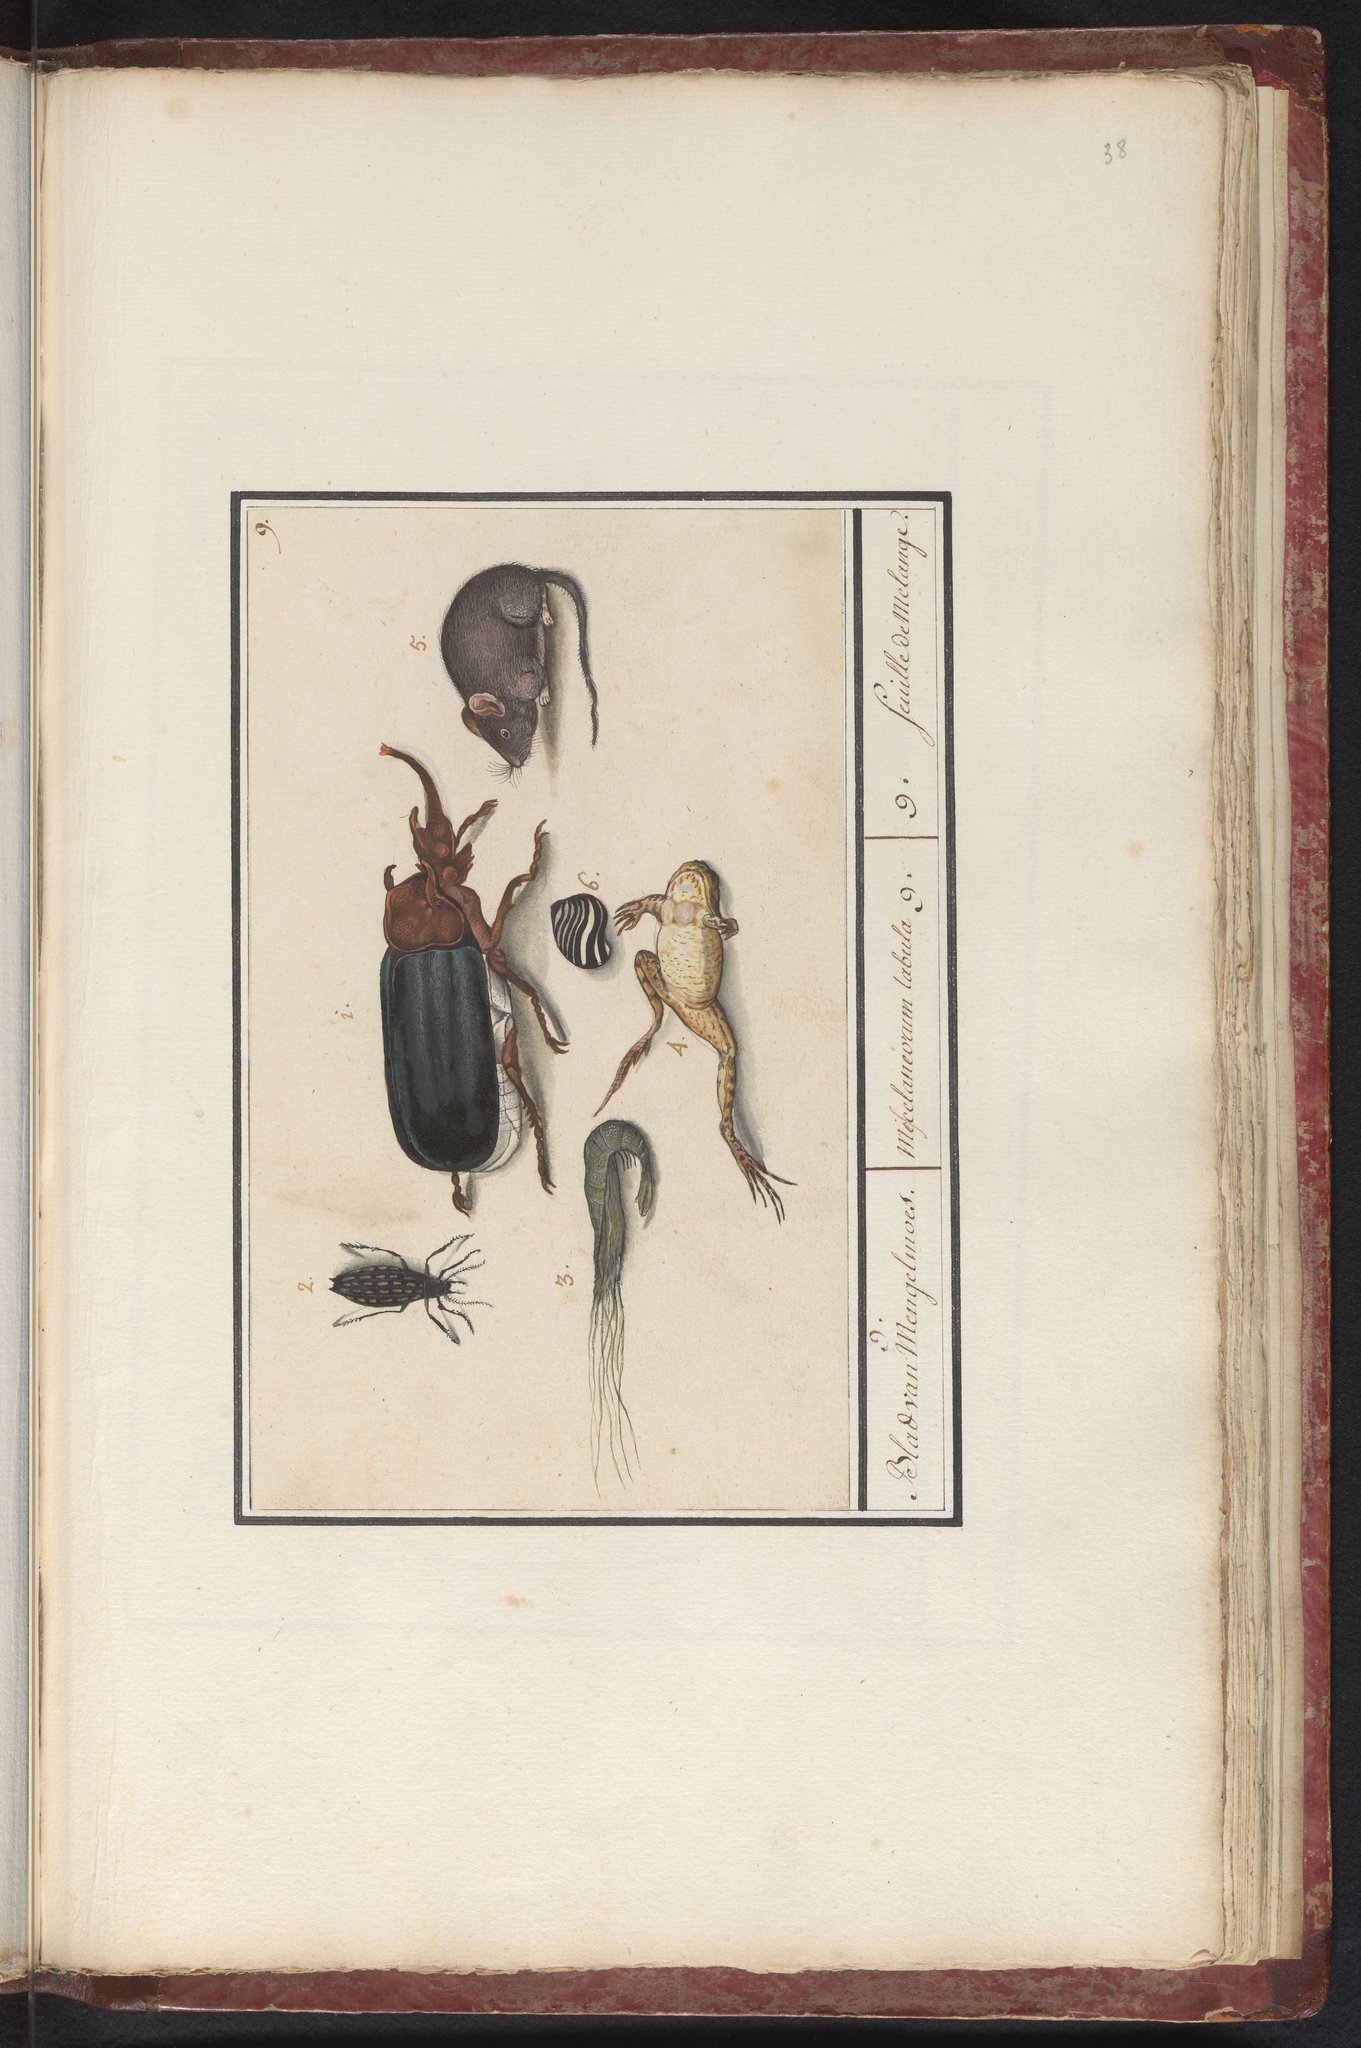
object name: drawing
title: 9. Blad van Mengelmoes / Miscelaniorum tabula 9. / 9. feuille de melange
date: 1596-1610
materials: chalk, paint, ink, lacquer, paper, pencil, watercolor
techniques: brush, pen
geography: prague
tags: tailless amphibians: frog, rodents: mouse, crustaceans: shrimp, insects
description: Blad met de negende natuurhistorische ensemble met dieren en planten, nummers 1-6. Twee kevers, kikker, muis, garnaal en schelp. Genummerd rechtsboven: 9. Onderdeel van het zevende album met tekeningen van reptielen, amfibieën en natuurhistorische ensembles. Het zevende van twaalf albums met aquarellen van dieren, vogels en planten bekend rond 1600, gemaakt in opdracht van keizer Rudolf II. Met toelichting in Nederlands, Latijn en Frans.